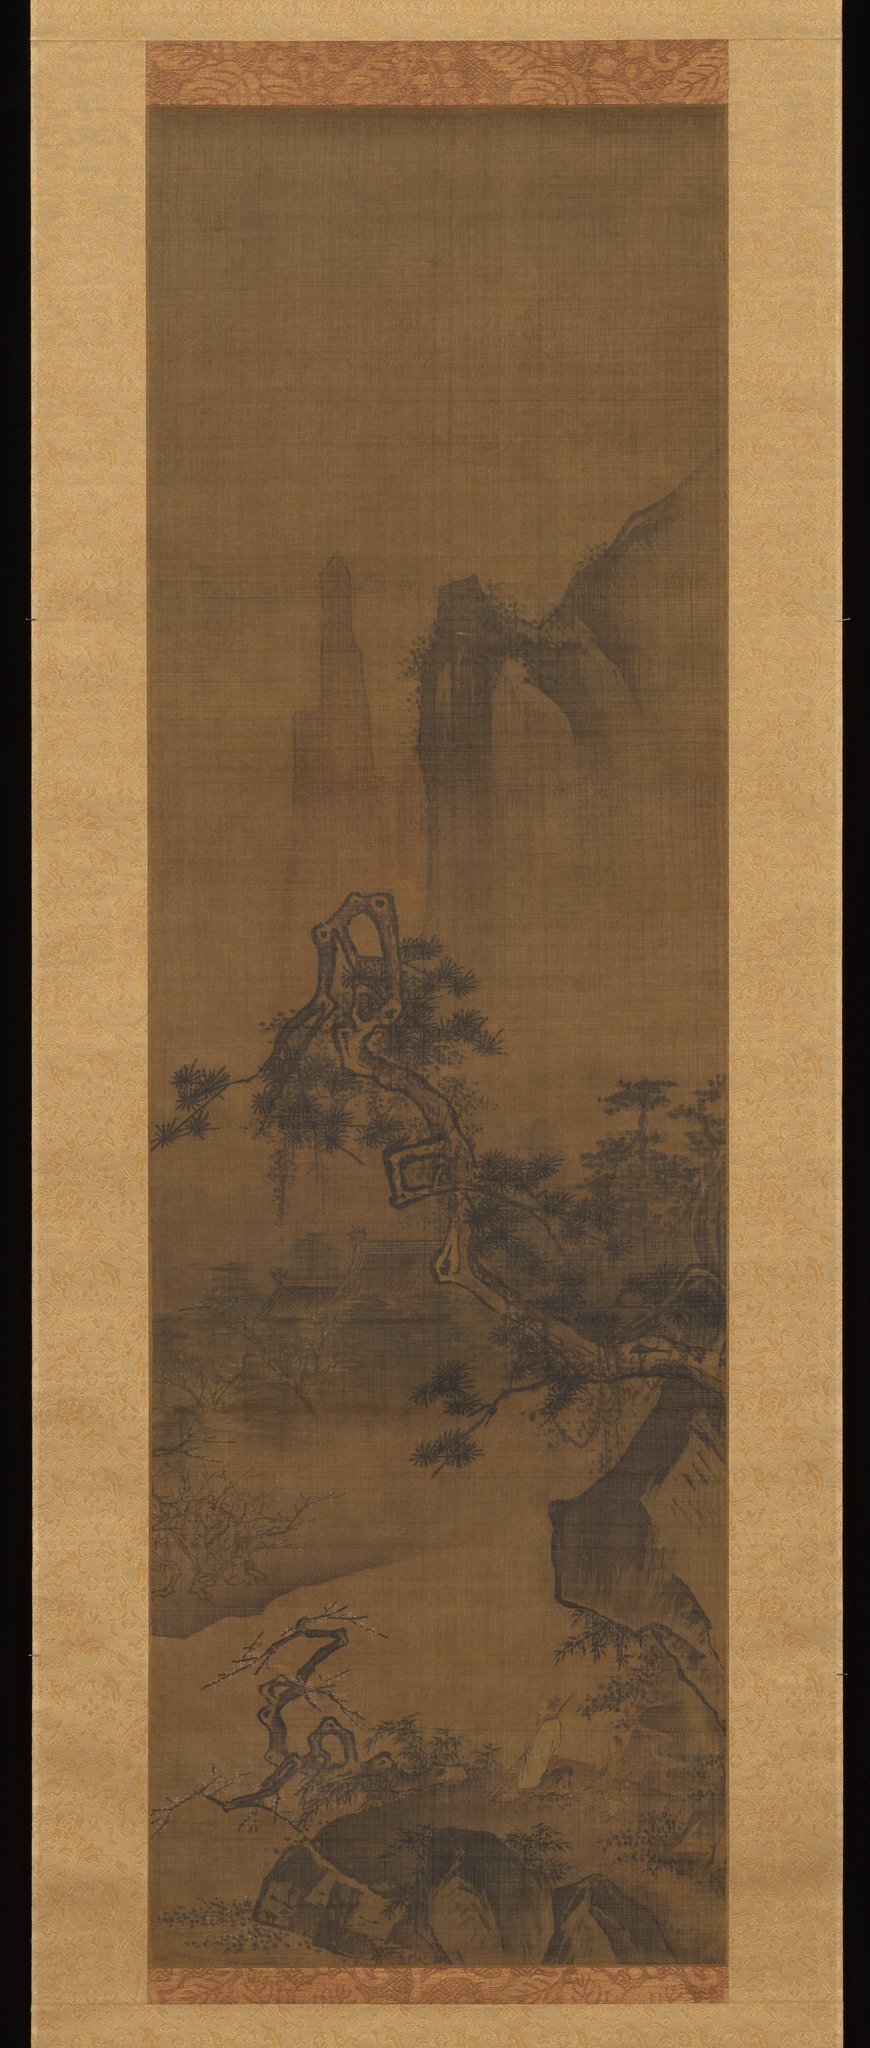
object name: hanging scroll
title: Scholar admiring plum blossoms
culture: chinese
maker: unidentified artist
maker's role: artist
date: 1201-1300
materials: ink, silk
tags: mountains,landscapes